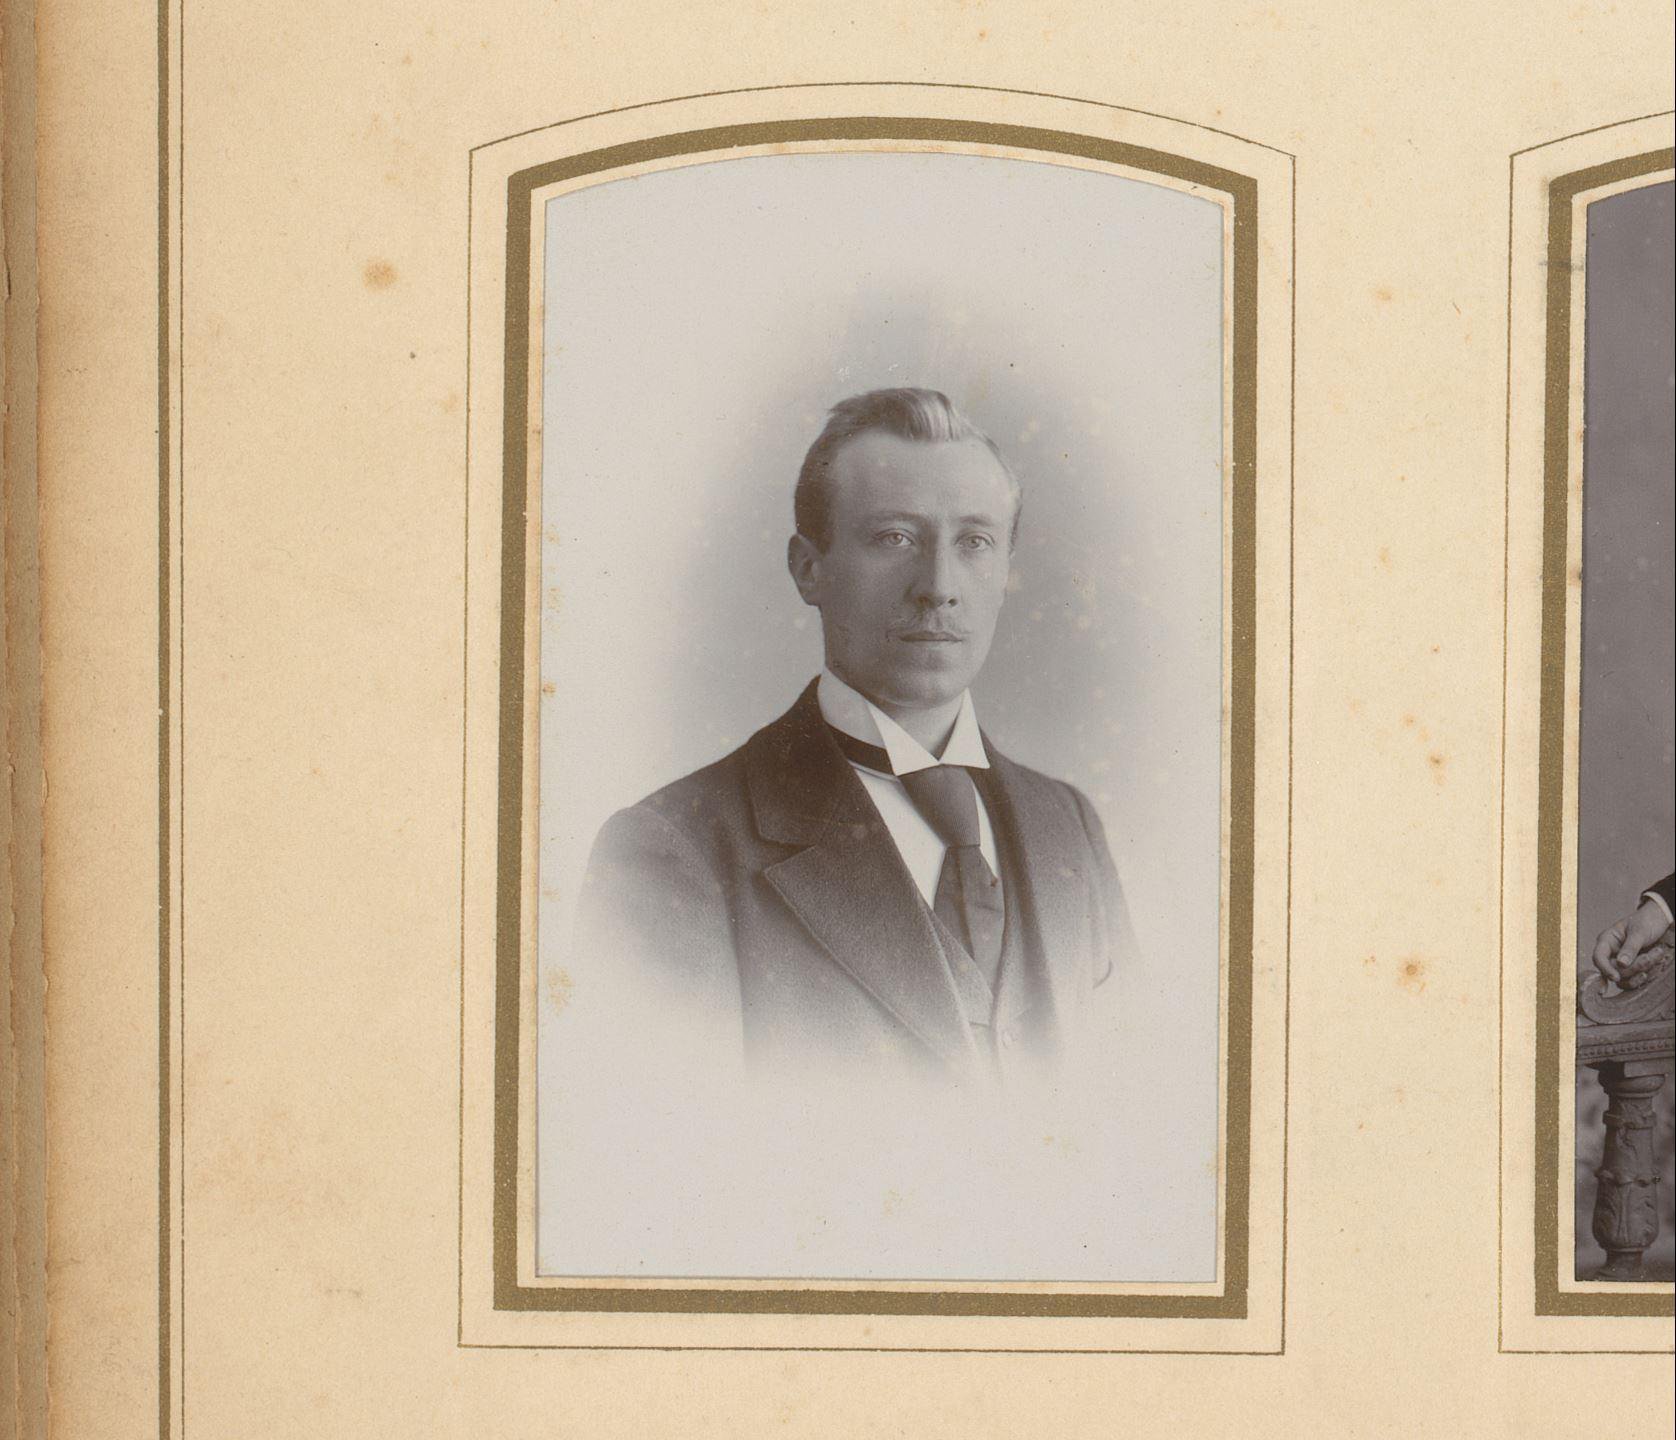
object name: album leaf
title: Portret van een man met snor en stropdas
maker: jan frederik blöte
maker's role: fotograaf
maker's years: 1865-1956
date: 1900-1928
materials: cardboard, photographic support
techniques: collodion silver print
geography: groningen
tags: moustache, historical persons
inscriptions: inscription: ‘J. F. Blöte/ Oosterstraat D 18. GRONINGEN.’